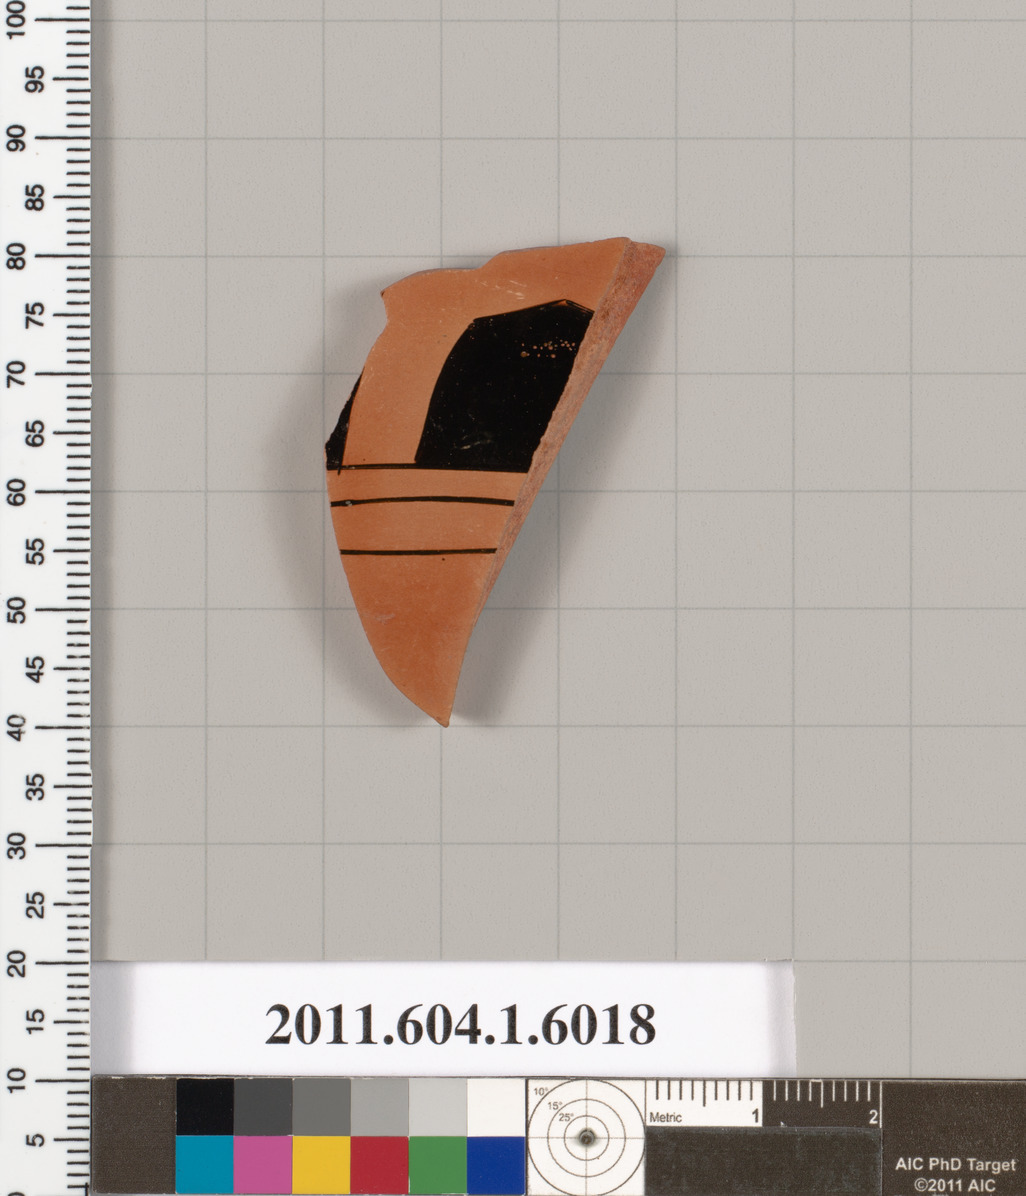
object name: kylix fragment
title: Terracotta fragment of a kylix (drinking cup)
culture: greek, attic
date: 510-500 BCE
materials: terracotta